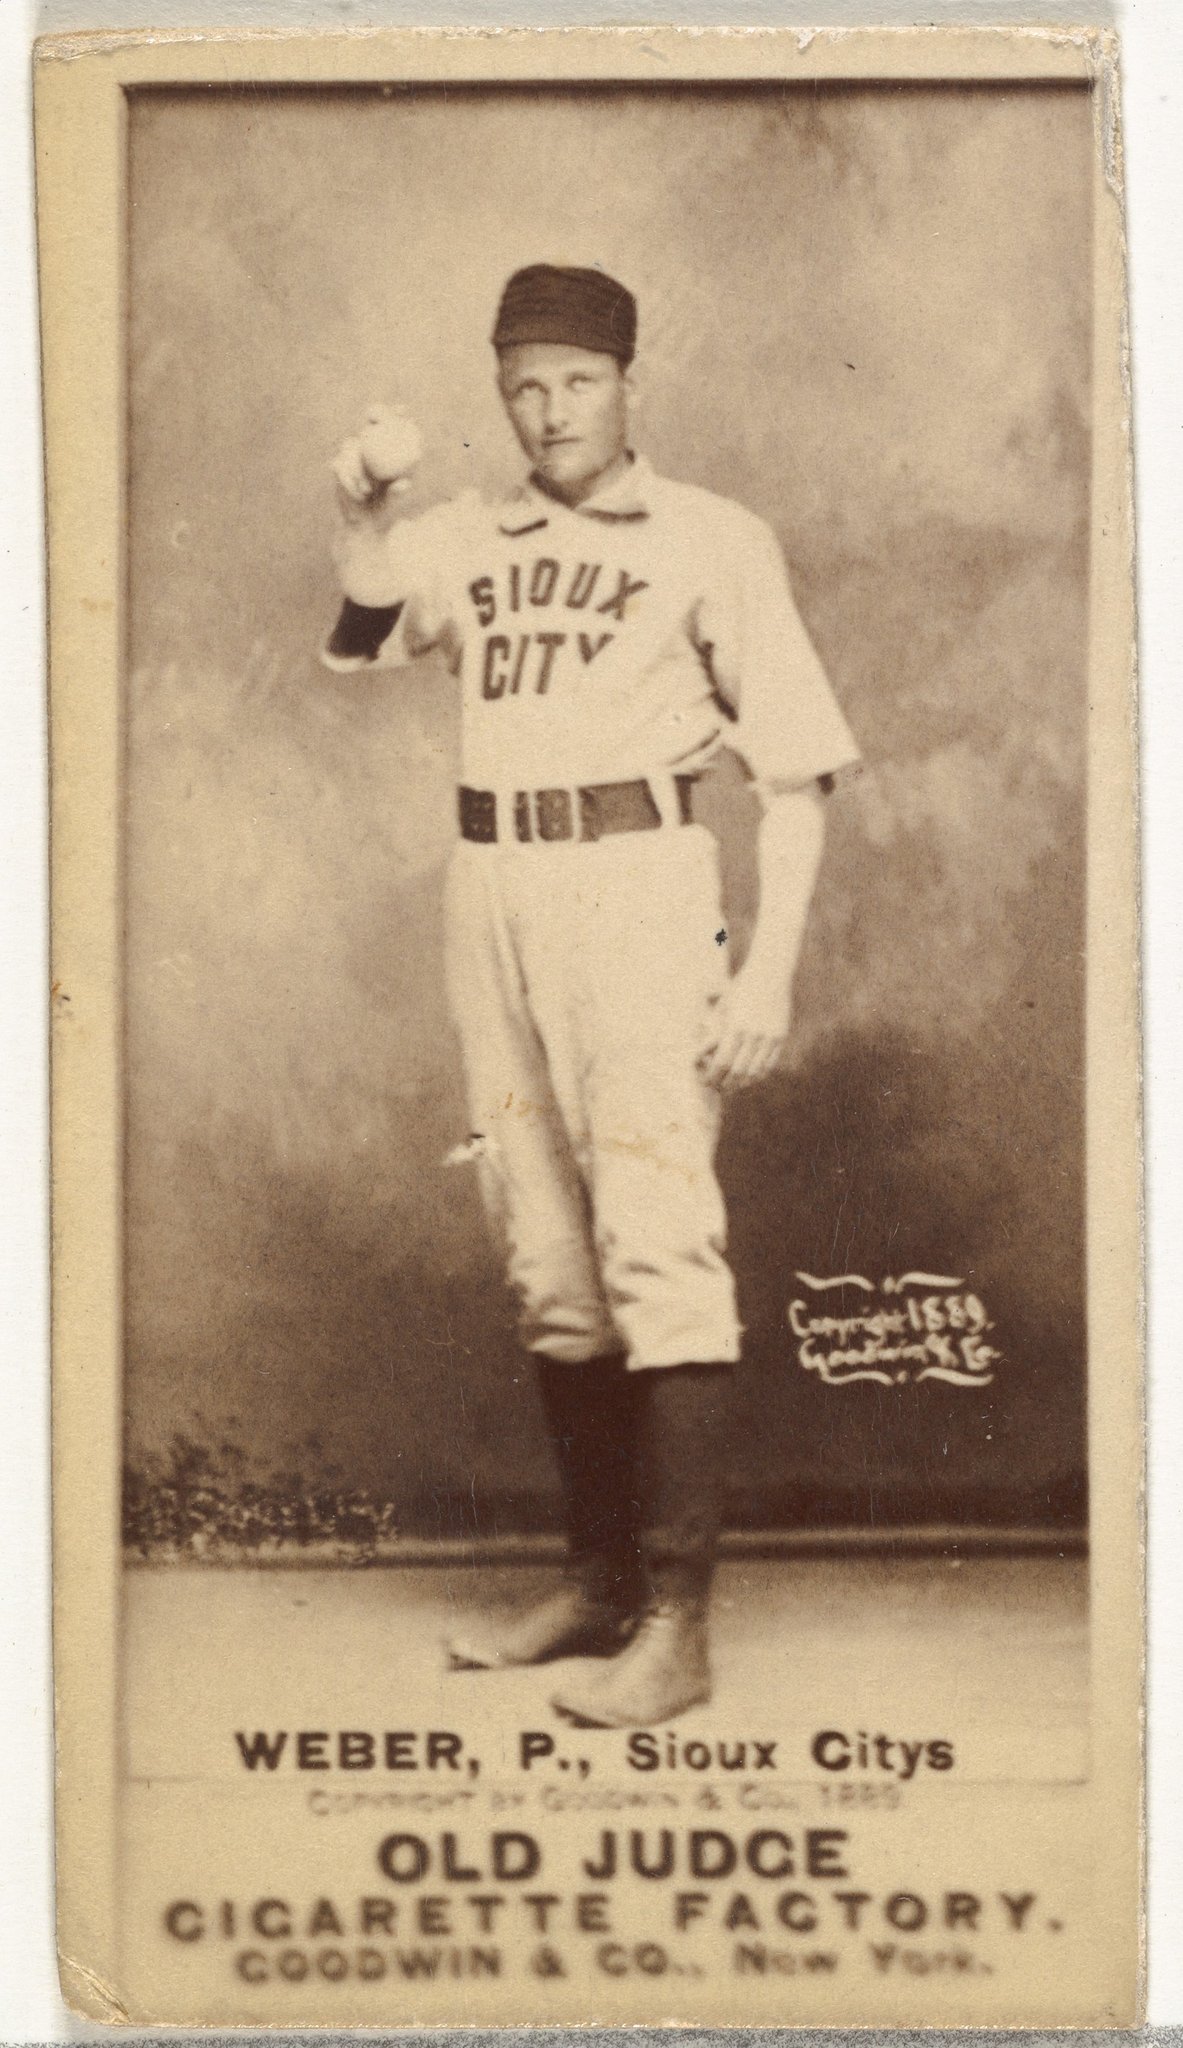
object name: baseball card, photograph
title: Peter W. Webber, Pitcher, Sioux City Corn Huskers, from the Old Judge series (N172) for Old Judge Cigarettes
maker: goodwin & company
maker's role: publisher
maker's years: 1850-1950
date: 1889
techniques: albumen silver print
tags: men,portraits,baseball,athletes